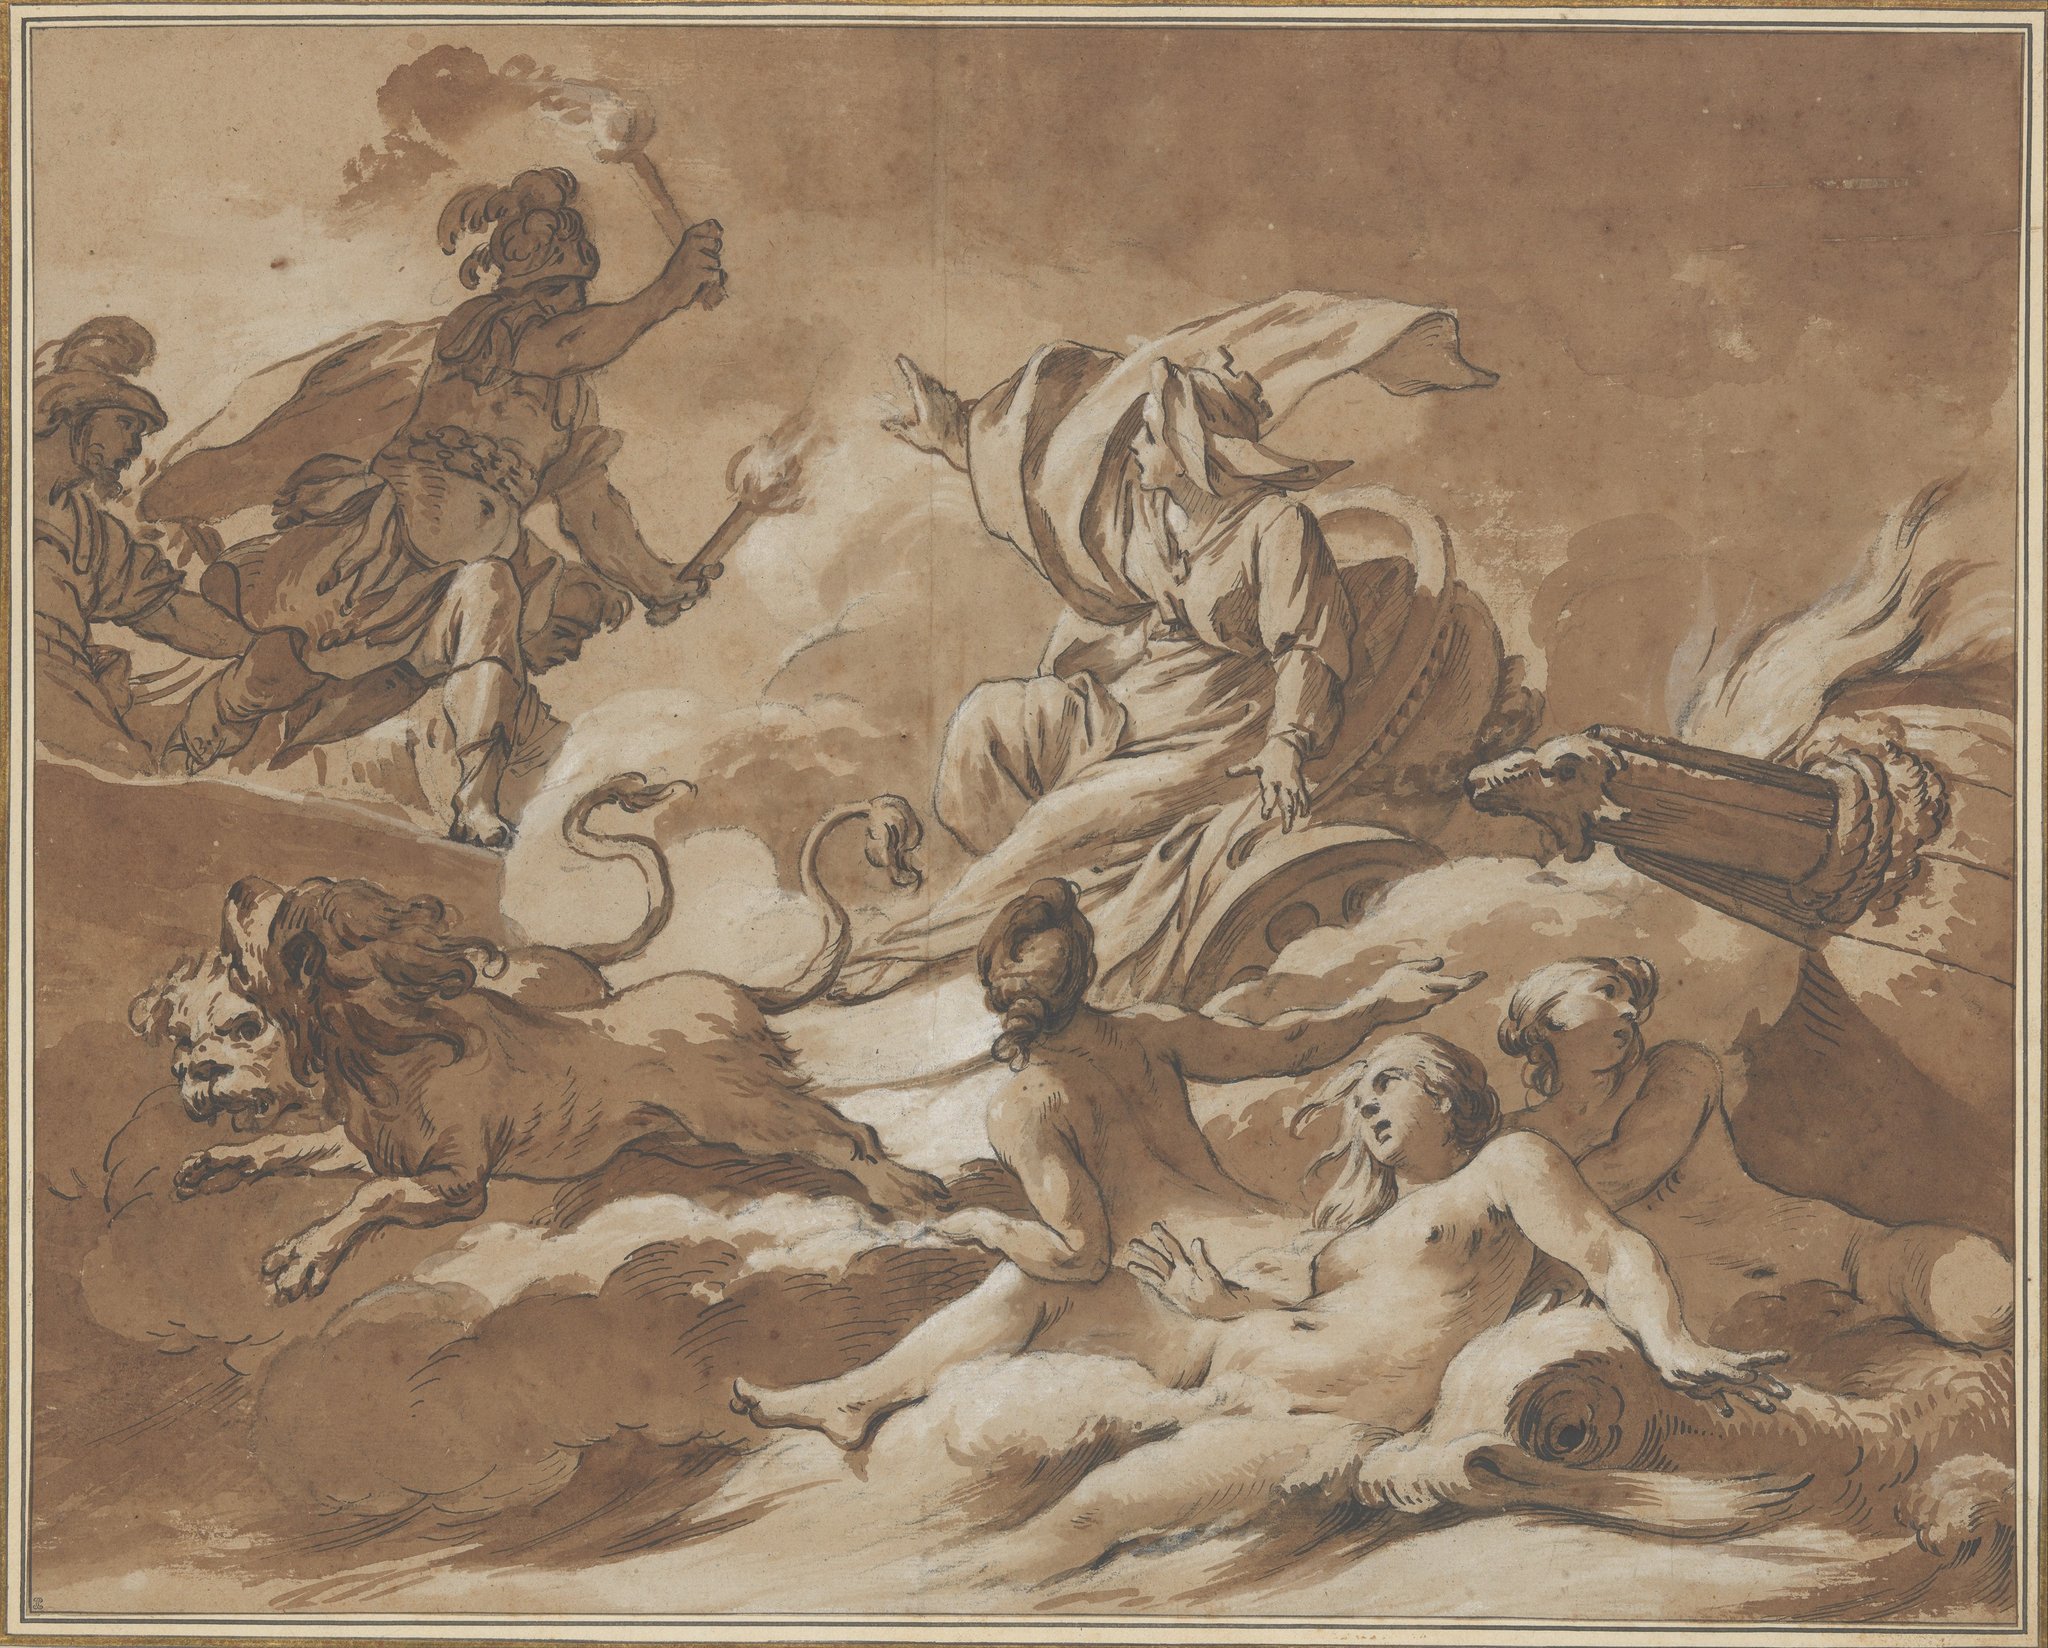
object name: drawing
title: Cybele Prevents Turnus from Setting Fire to the Trojan Fleet by Transforming the Ships into Sea Goddesses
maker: jean-baptiste marie pierre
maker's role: artist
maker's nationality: french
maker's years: 1714-1789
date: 1701-1800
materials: chalk, ink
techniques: brush, heightening, pen, wash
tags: men,female nudes,lions,goddess